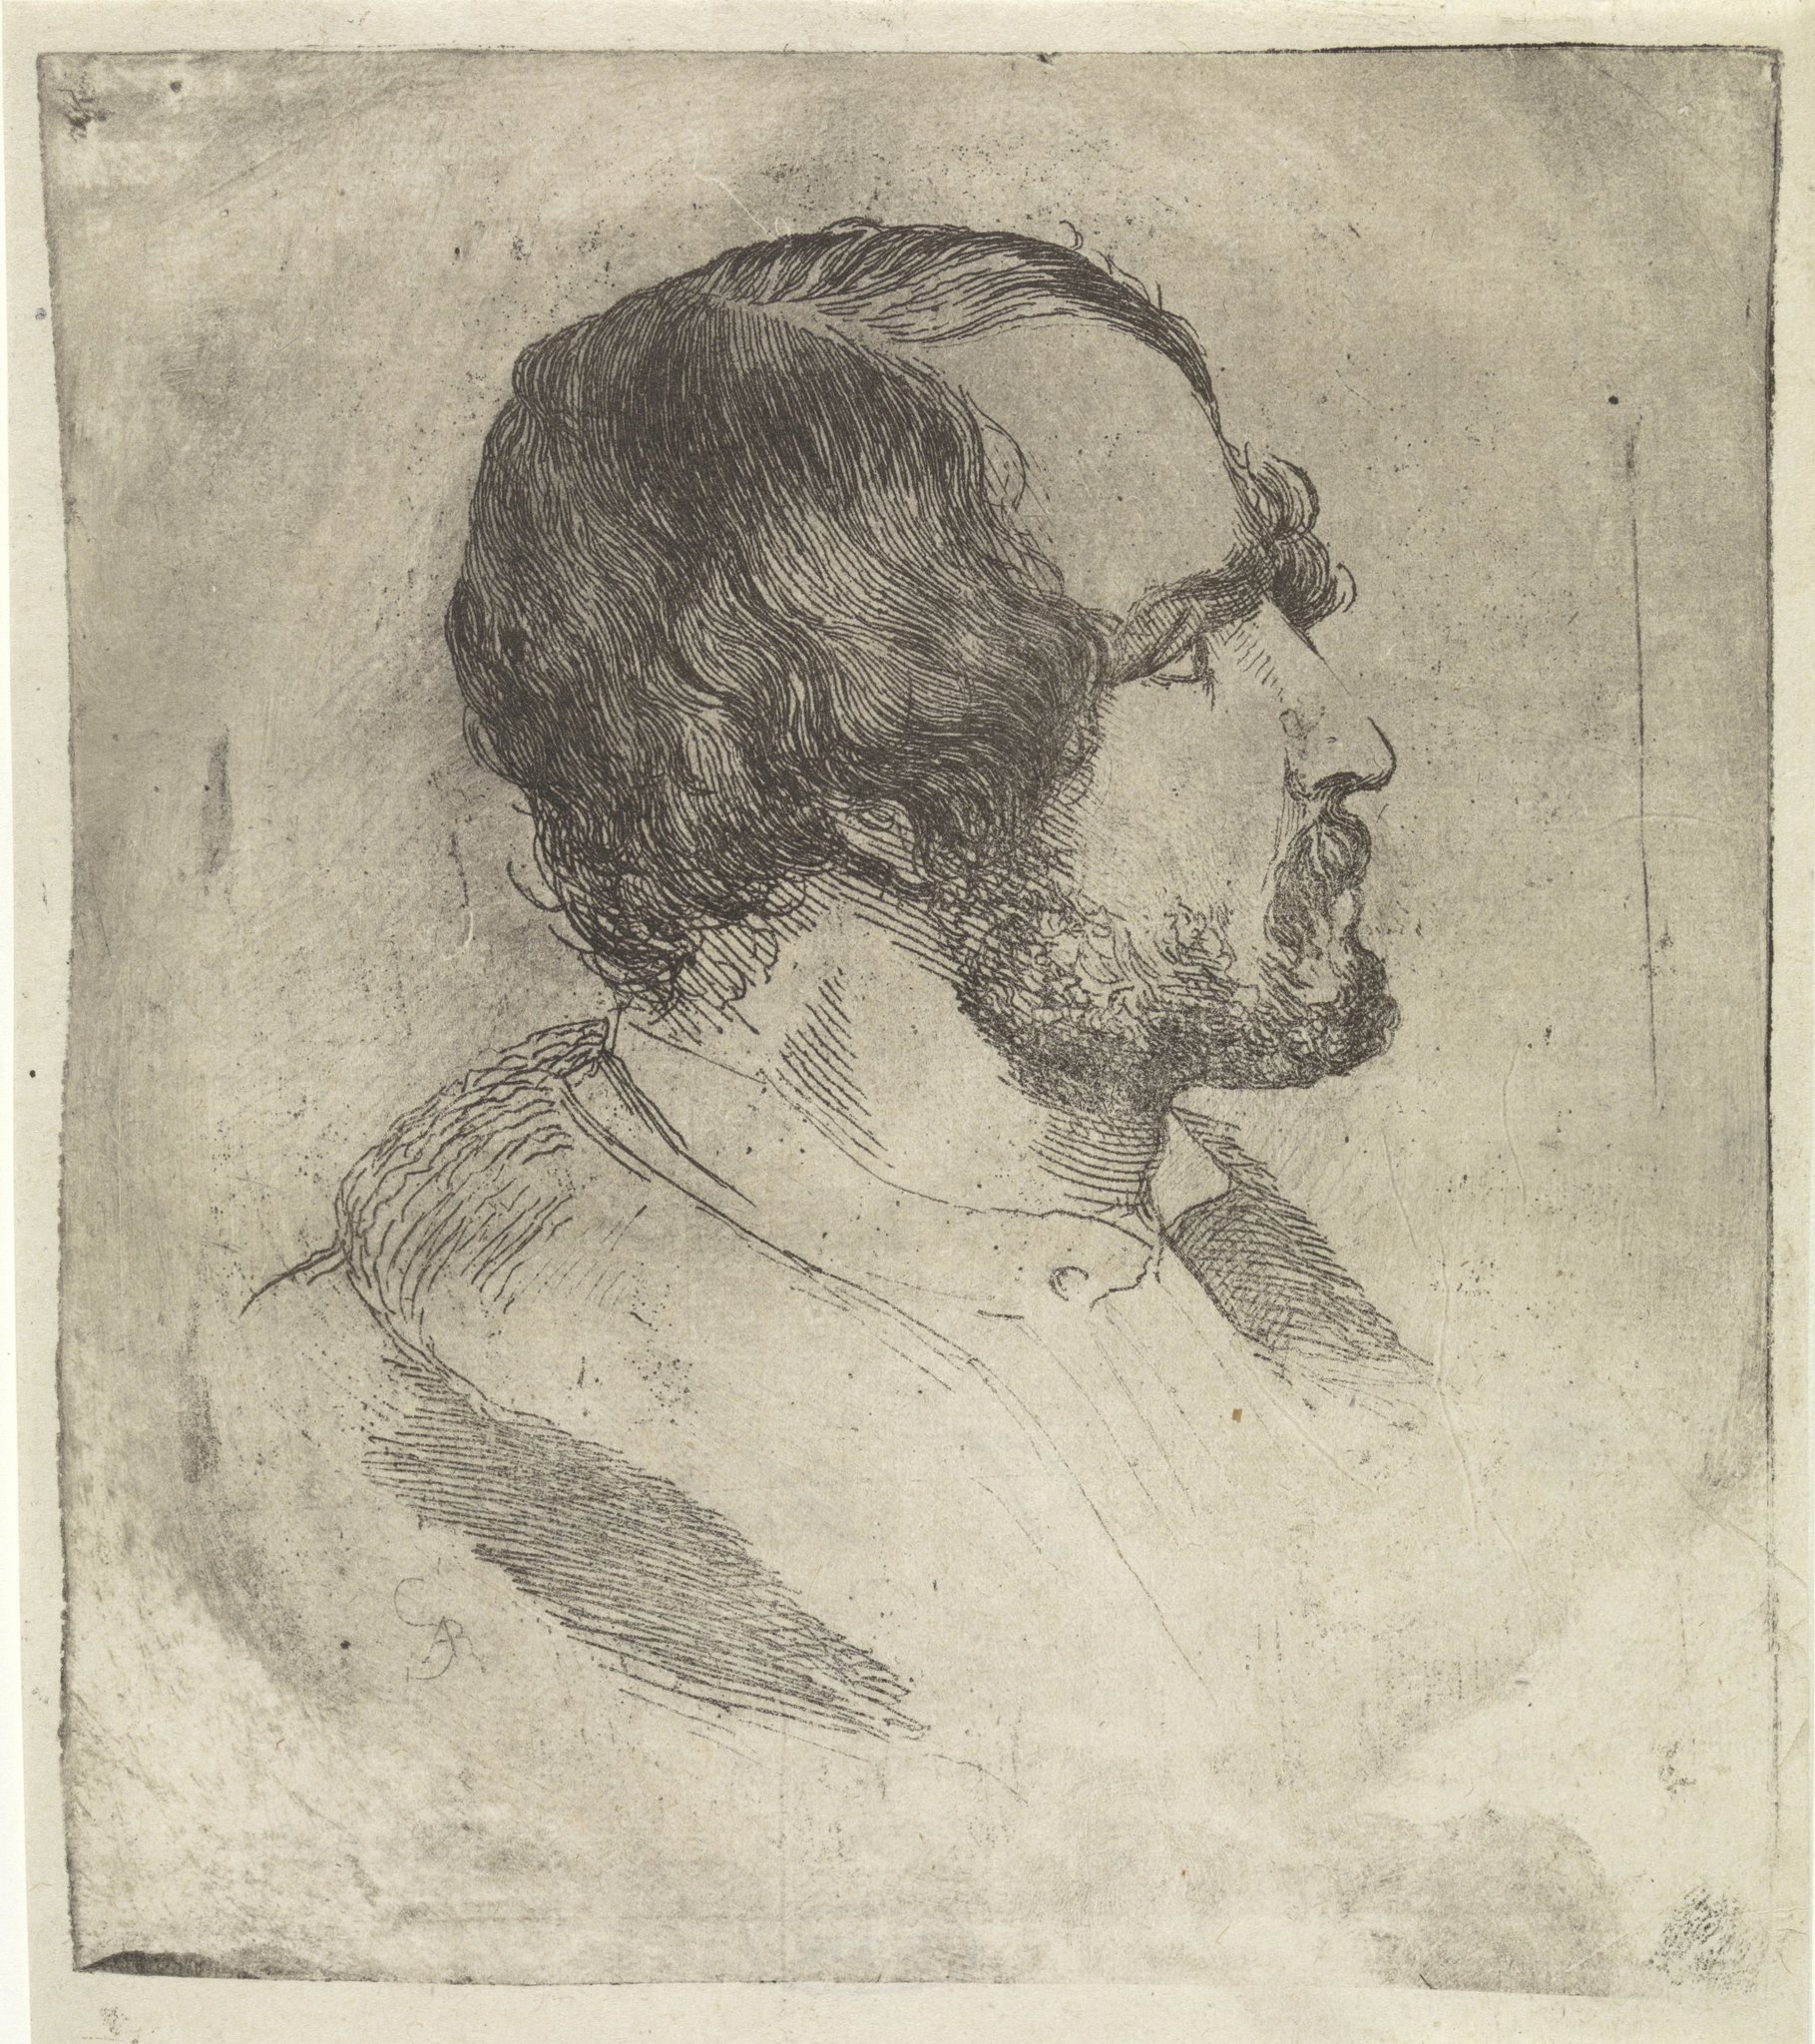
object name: print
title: Portret van prentmaker Alexander Schaepkens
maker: arnoud schaepkens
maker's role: print maker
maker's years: 1816-1904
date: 1831-1904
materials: paper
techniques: etching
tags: maastricht, print maker, draughtsman, alexander schaepkens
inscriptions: collector's mark: Lugt 2228